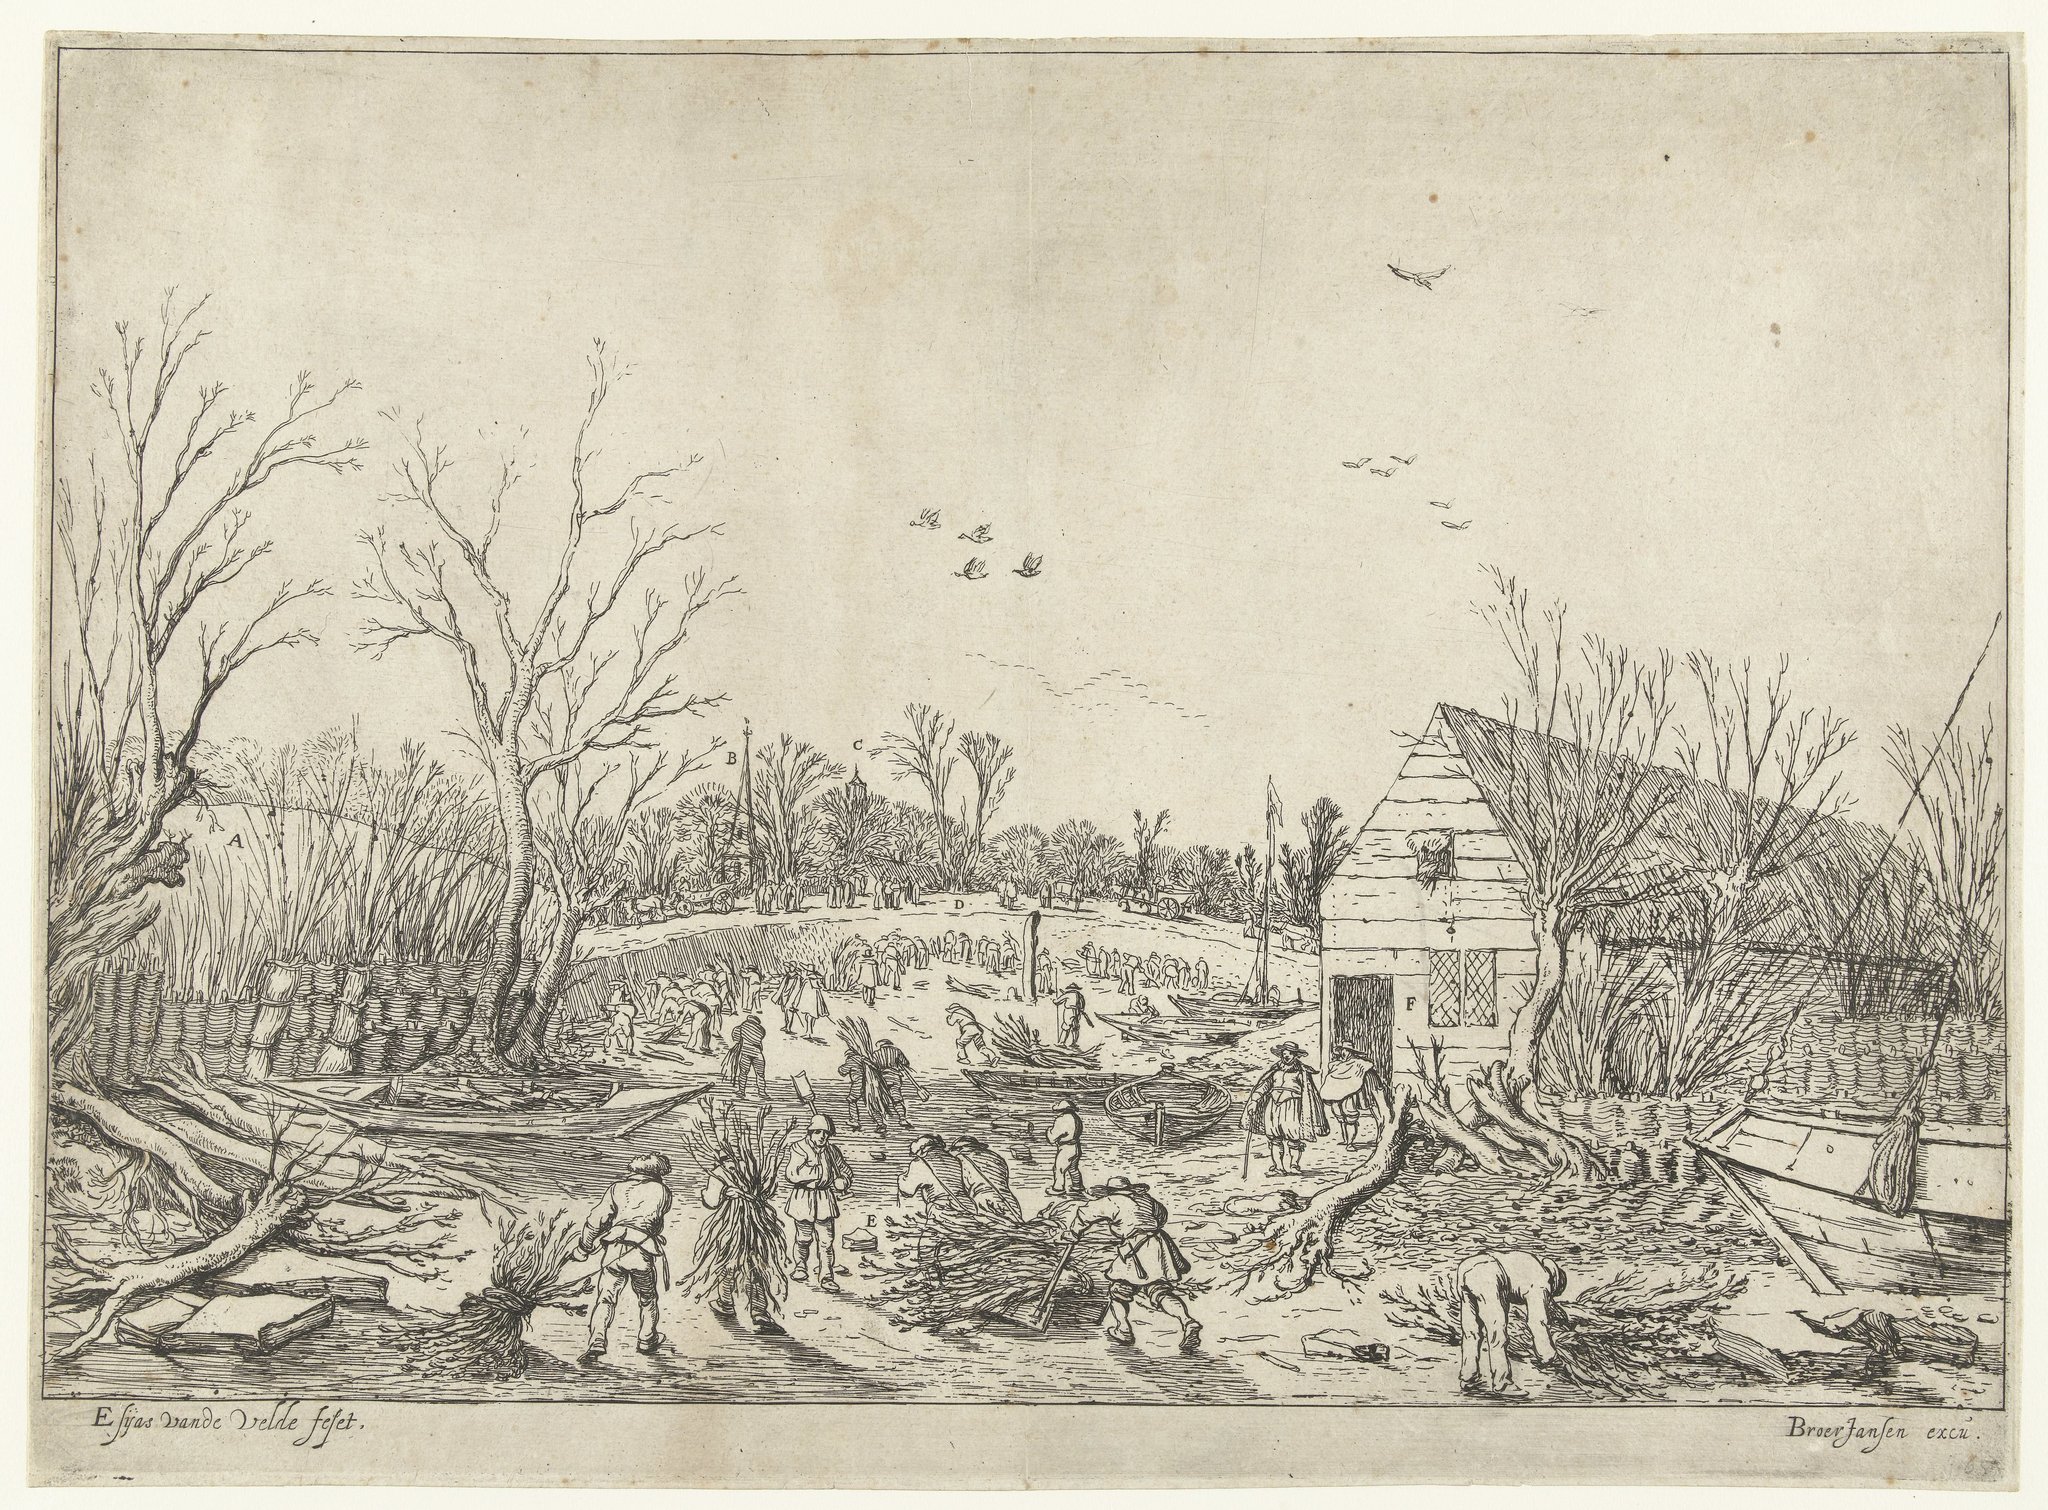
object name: print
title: Herstelwerkzaamheden aan de doorgebroken Lekdijk bij 't Waal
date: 1624-1640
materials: paper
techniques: etching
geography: netherlands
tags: dike-break, dry river, river bed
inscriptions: inscription: ‘J 64’, collector's mark: Lugt 240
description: De doorgebroken noordelijke Lekdijk in 1624. Mannen met takkenbossen op hun rug lopend door de droge rivierbedding van de Lek. Boten zijn drooggelegd. Met takken wordt de Lekdijk hersteld. In de verte de kerktoren van 't Waal en de Domtoren van Utrecht.